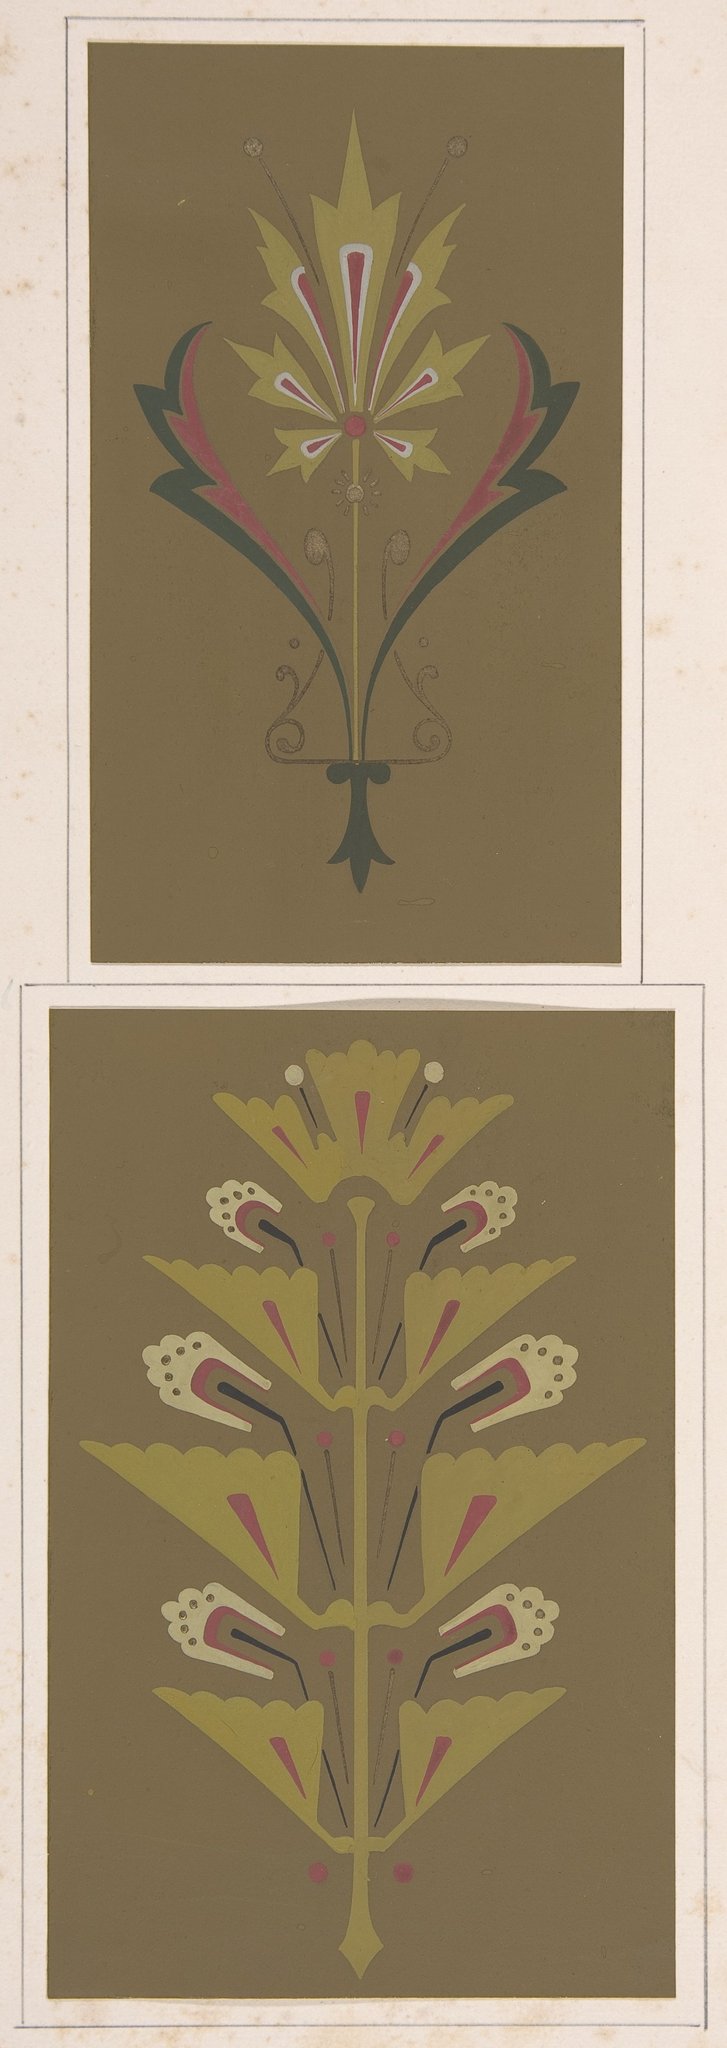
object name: drawing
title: Design drawing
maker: christopher dresser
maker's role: designer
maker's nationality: british, scottish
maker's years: 1834-1904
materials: gouache, graphite, ink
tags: leaves